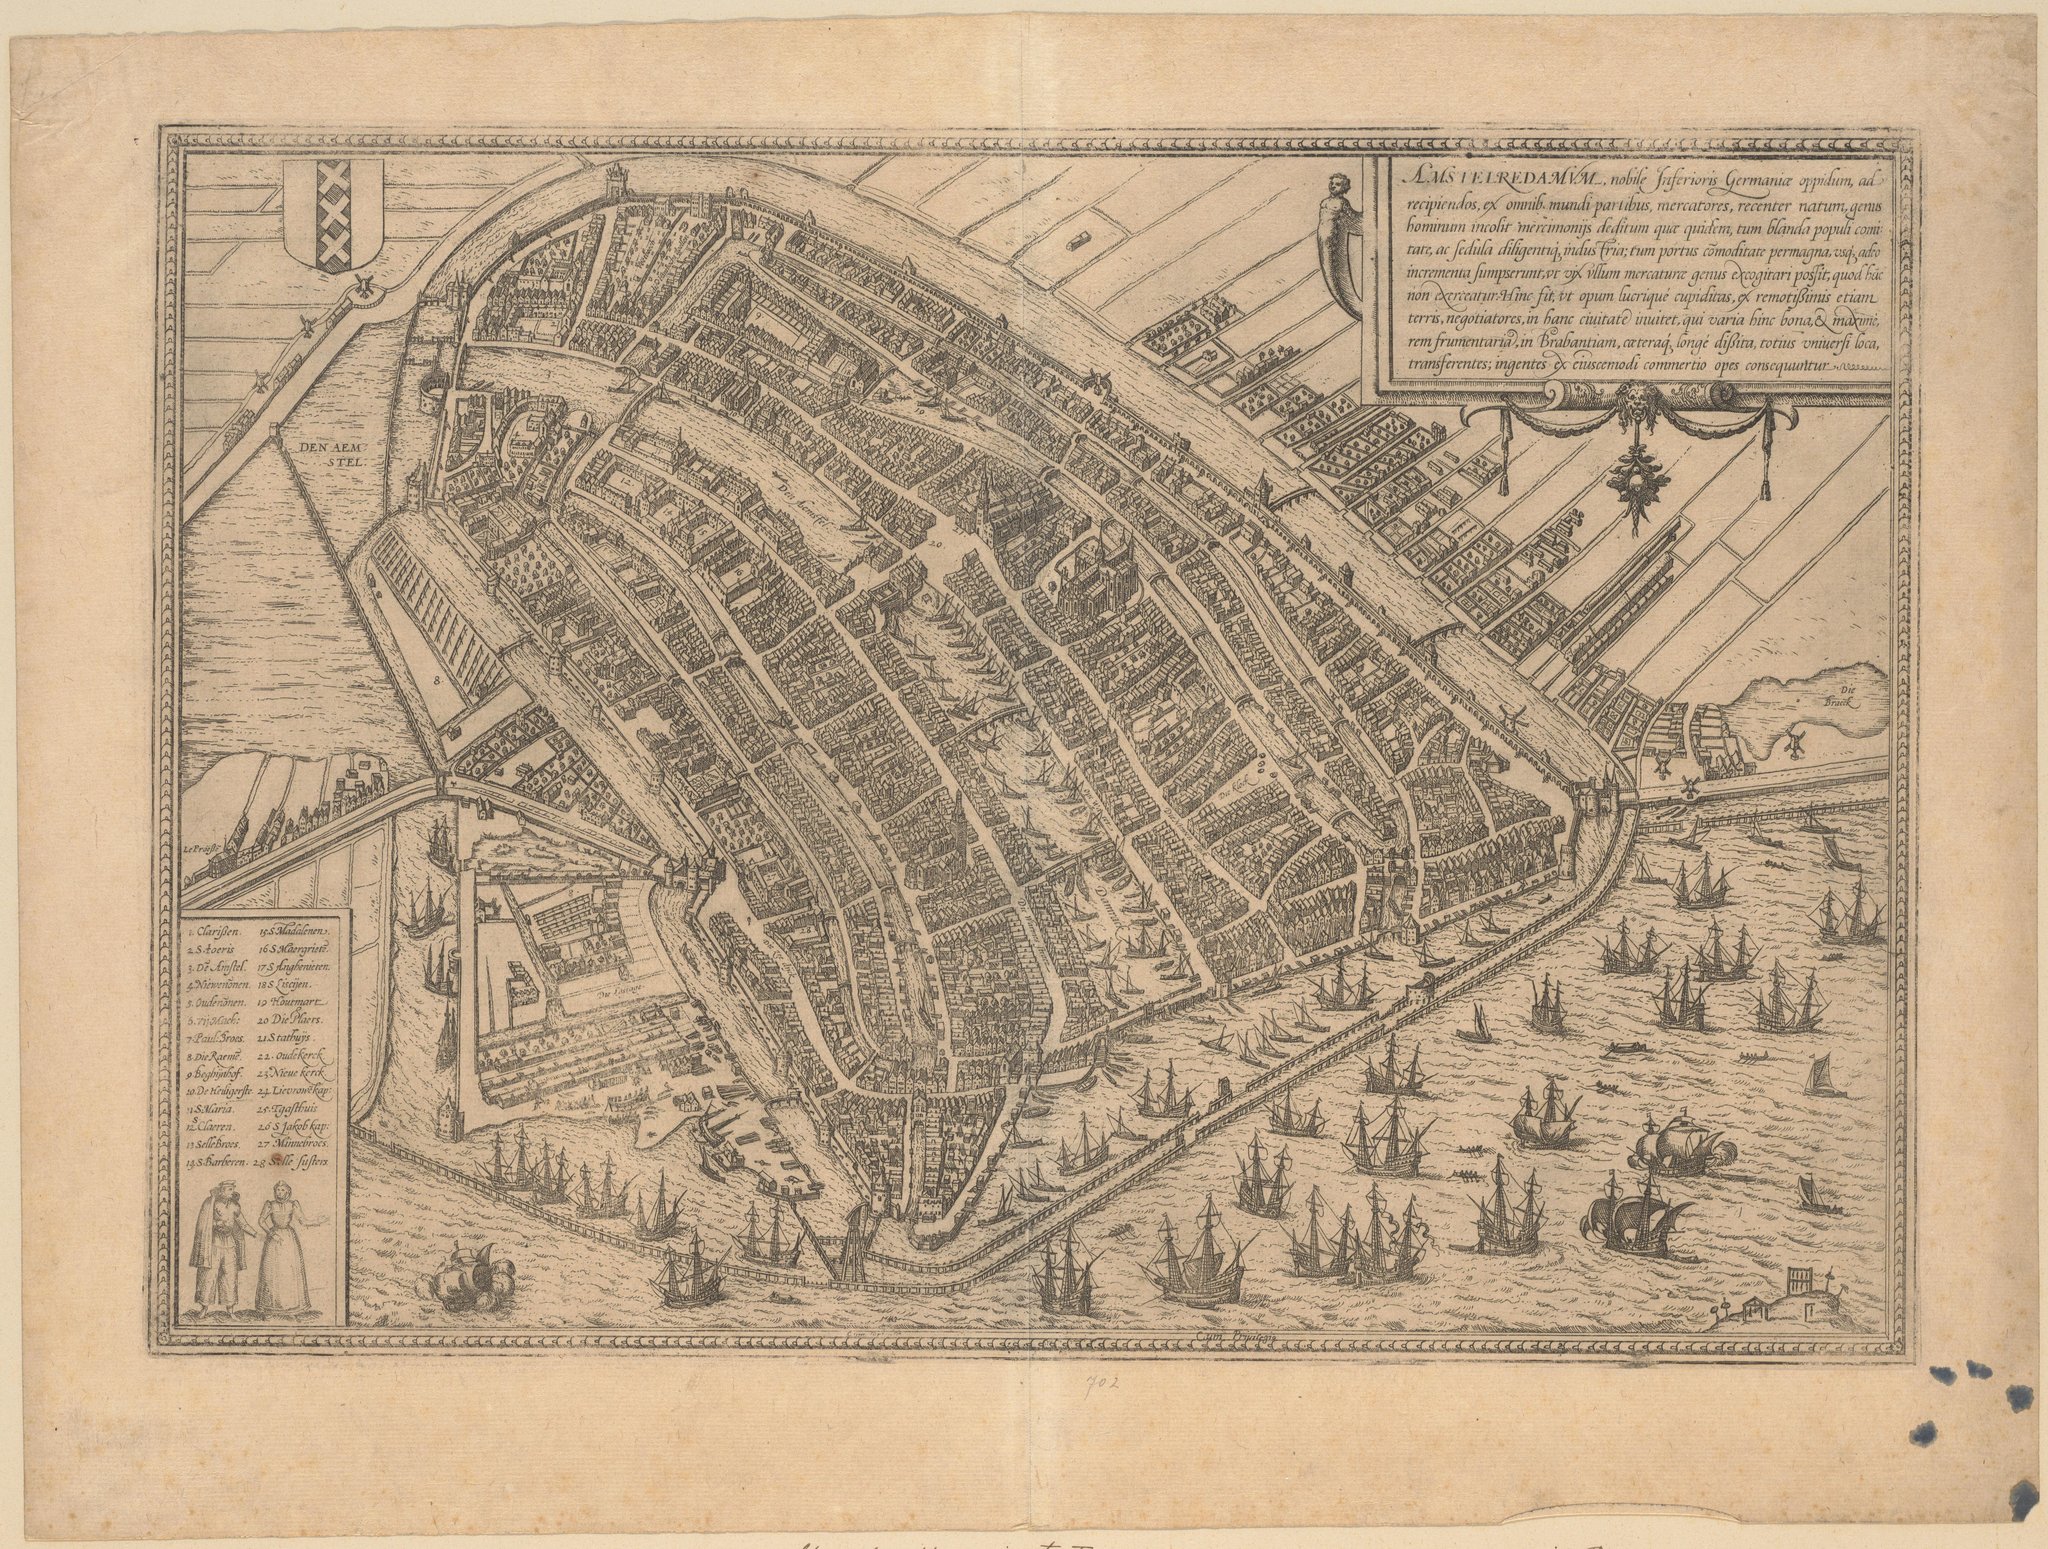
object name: print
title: Plattegrond van Amsterdam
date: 1618-1657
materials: paper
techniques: engraving, etching, letterpress printing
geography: cologne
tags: coat of arms (as symbol of the state, etc.) (+ city; municipal), folk costume, regional costume, maps of cities, amsterdam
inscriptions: collector's mark: Lugt 1641b